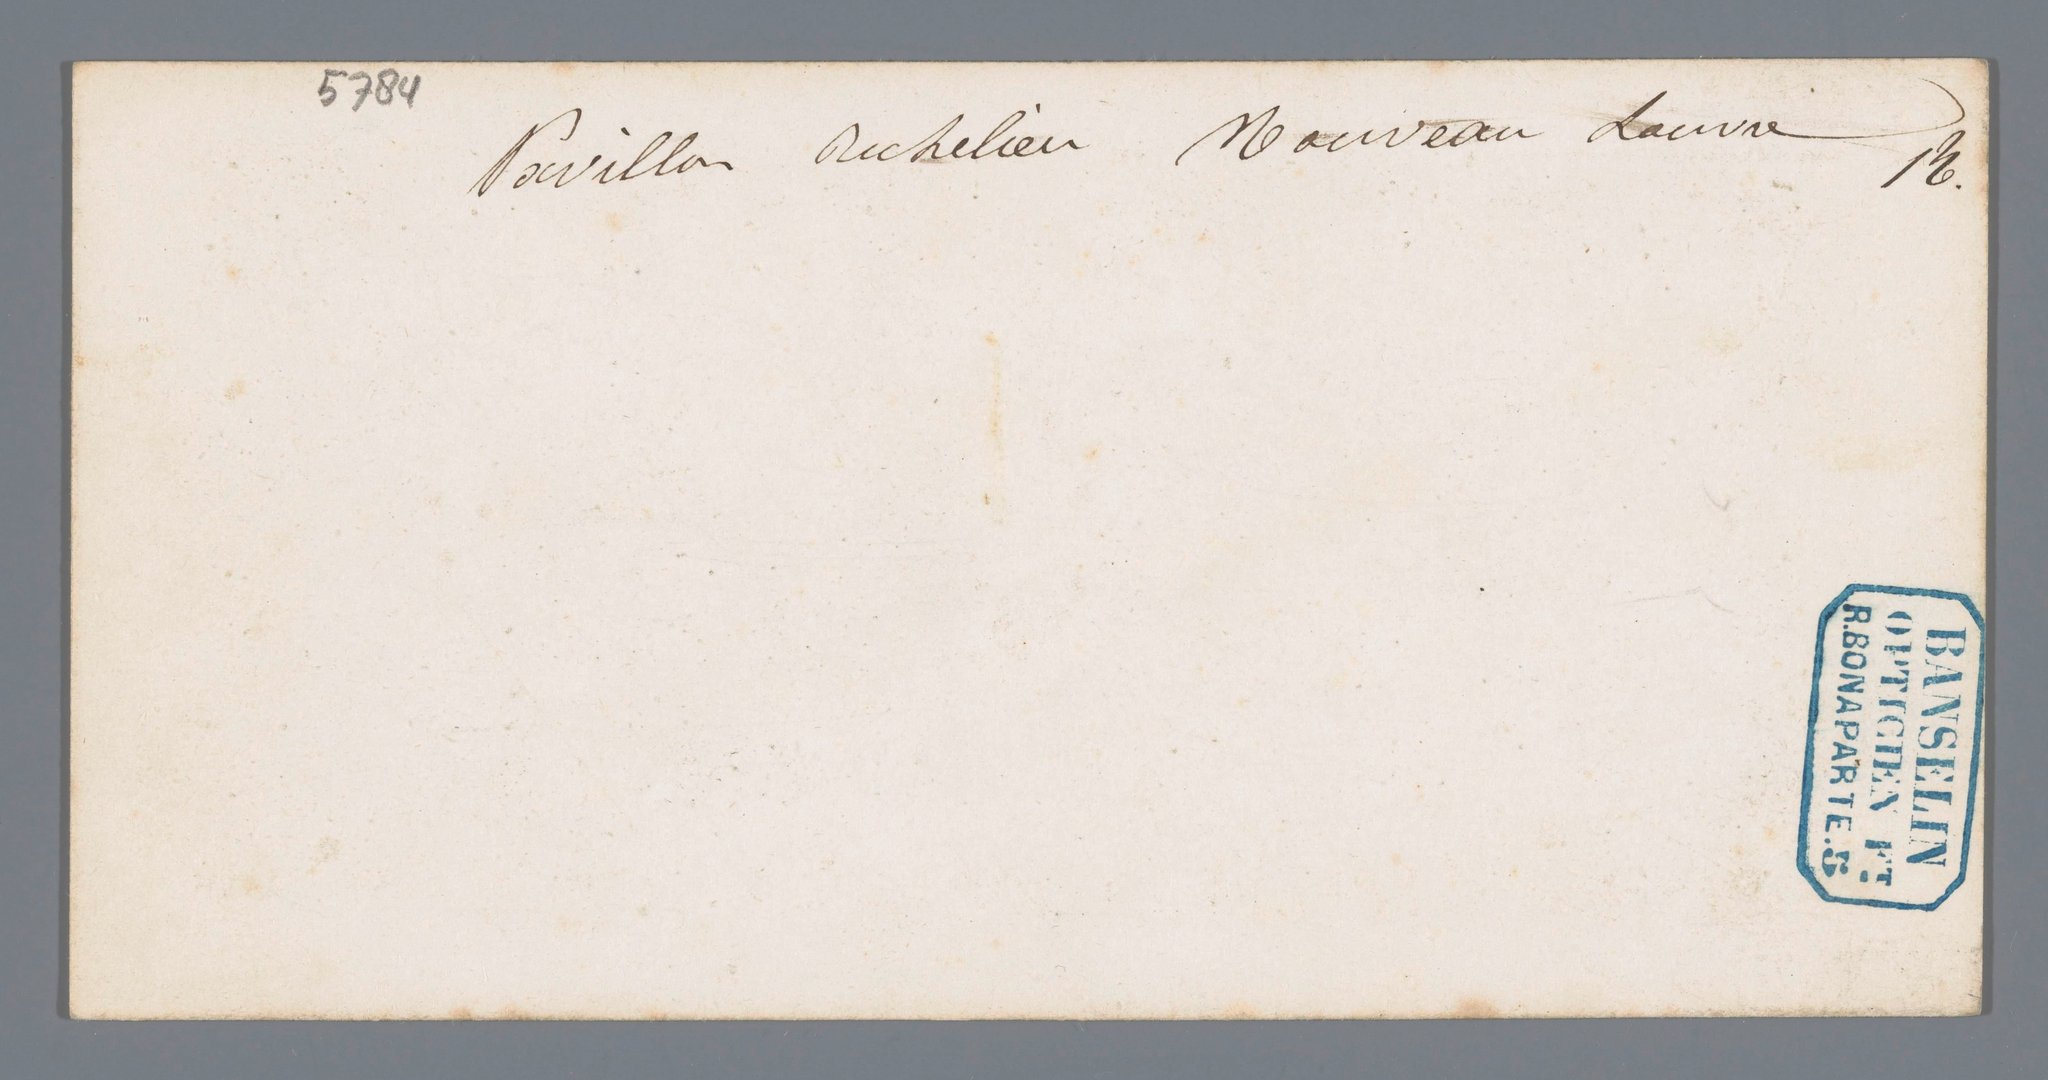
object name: stereograph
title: Gezicht op het Pavillon Richelieu van het Musée du Louvre in Parijs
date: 1850-1870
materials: cardboard, photographic support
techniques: albumen print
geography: paris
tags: permanent exhibition, museum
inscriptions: inscription: ‘Pavillon Richelieu Nouveau Louvre’, number: ‘14.’, name: ‘Banselin Opticien Ft R.Bonaparte.5’